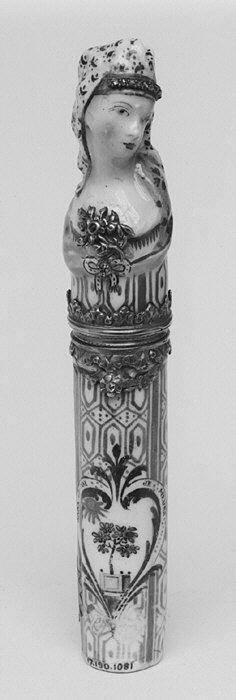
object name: needle case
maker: meissen manufactory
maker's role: manufactory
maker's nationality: german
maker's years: 1710-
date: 1701-1800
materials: gold, porcelain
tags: women